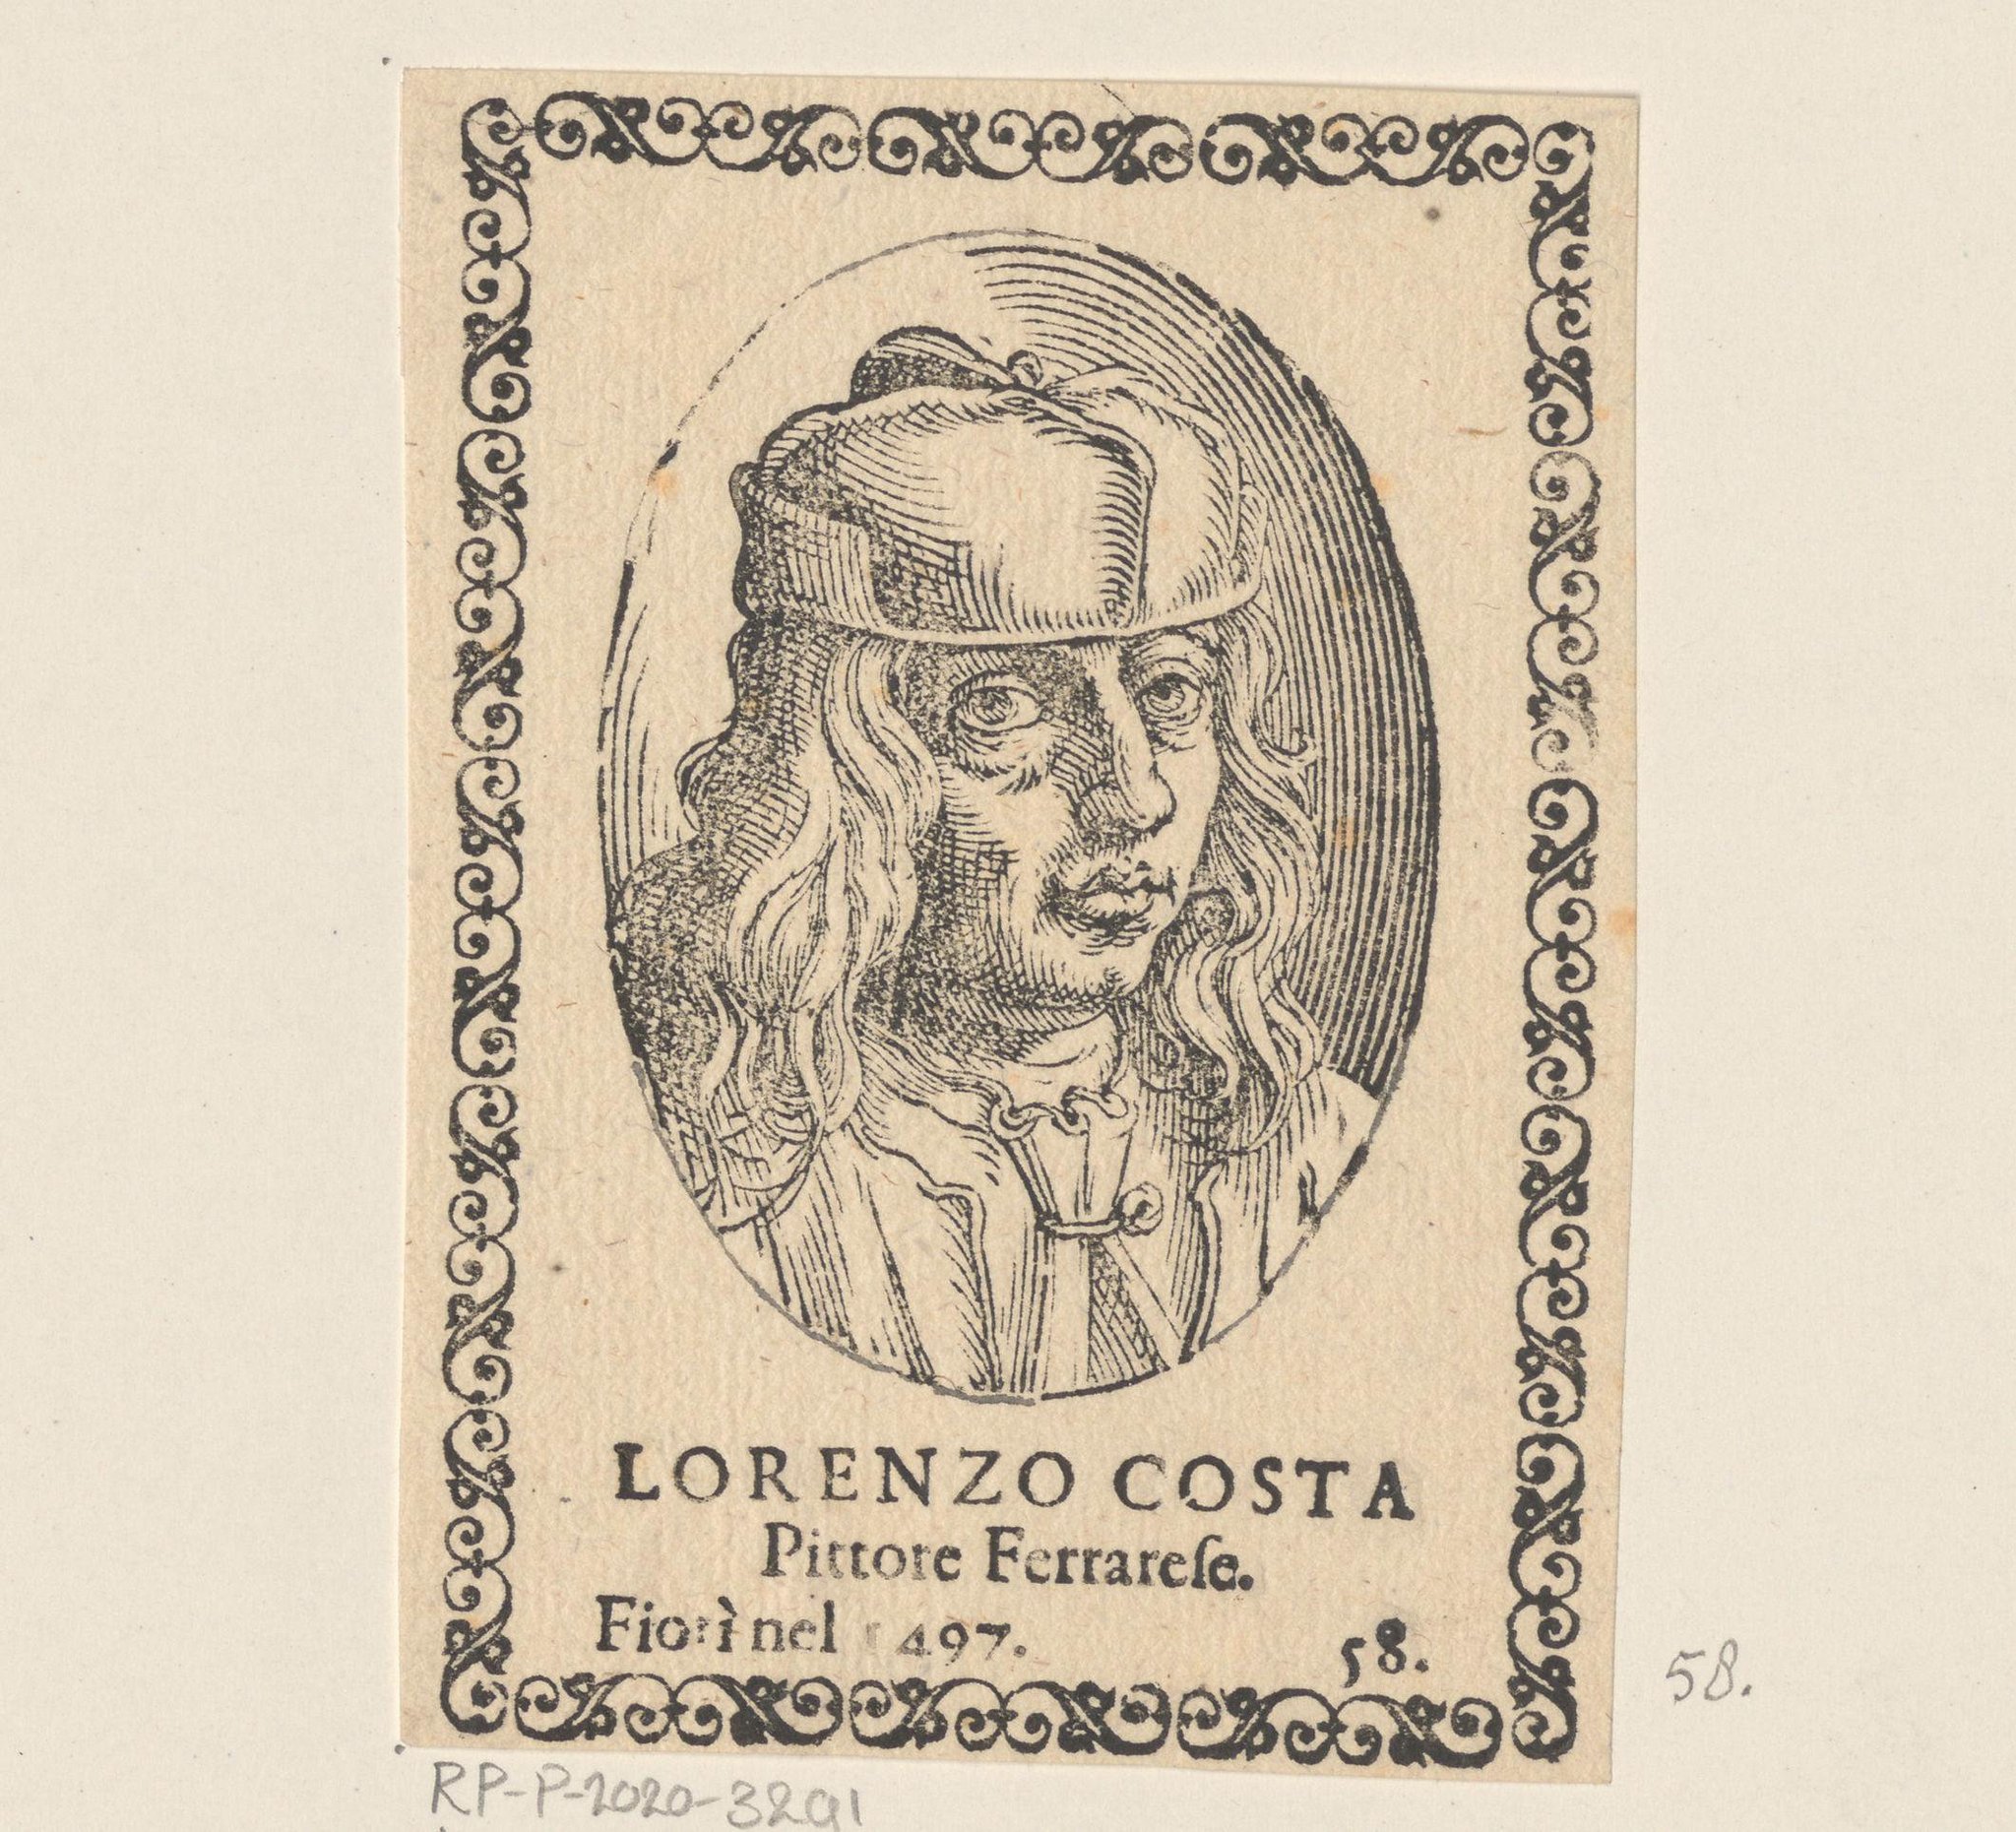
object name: print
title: Portret van Lorenzo Costa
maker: Anonymous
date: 1568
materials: paper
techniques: letterpress printing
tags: lorenzo costa, historical persons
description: Prent mogelijk uit: Vasari, Giorgio. Le vite de' più eccellenti pittori, scultori, e architettori da Cimabue insino a' tempi nostri. Florence: Giunti, 1568.